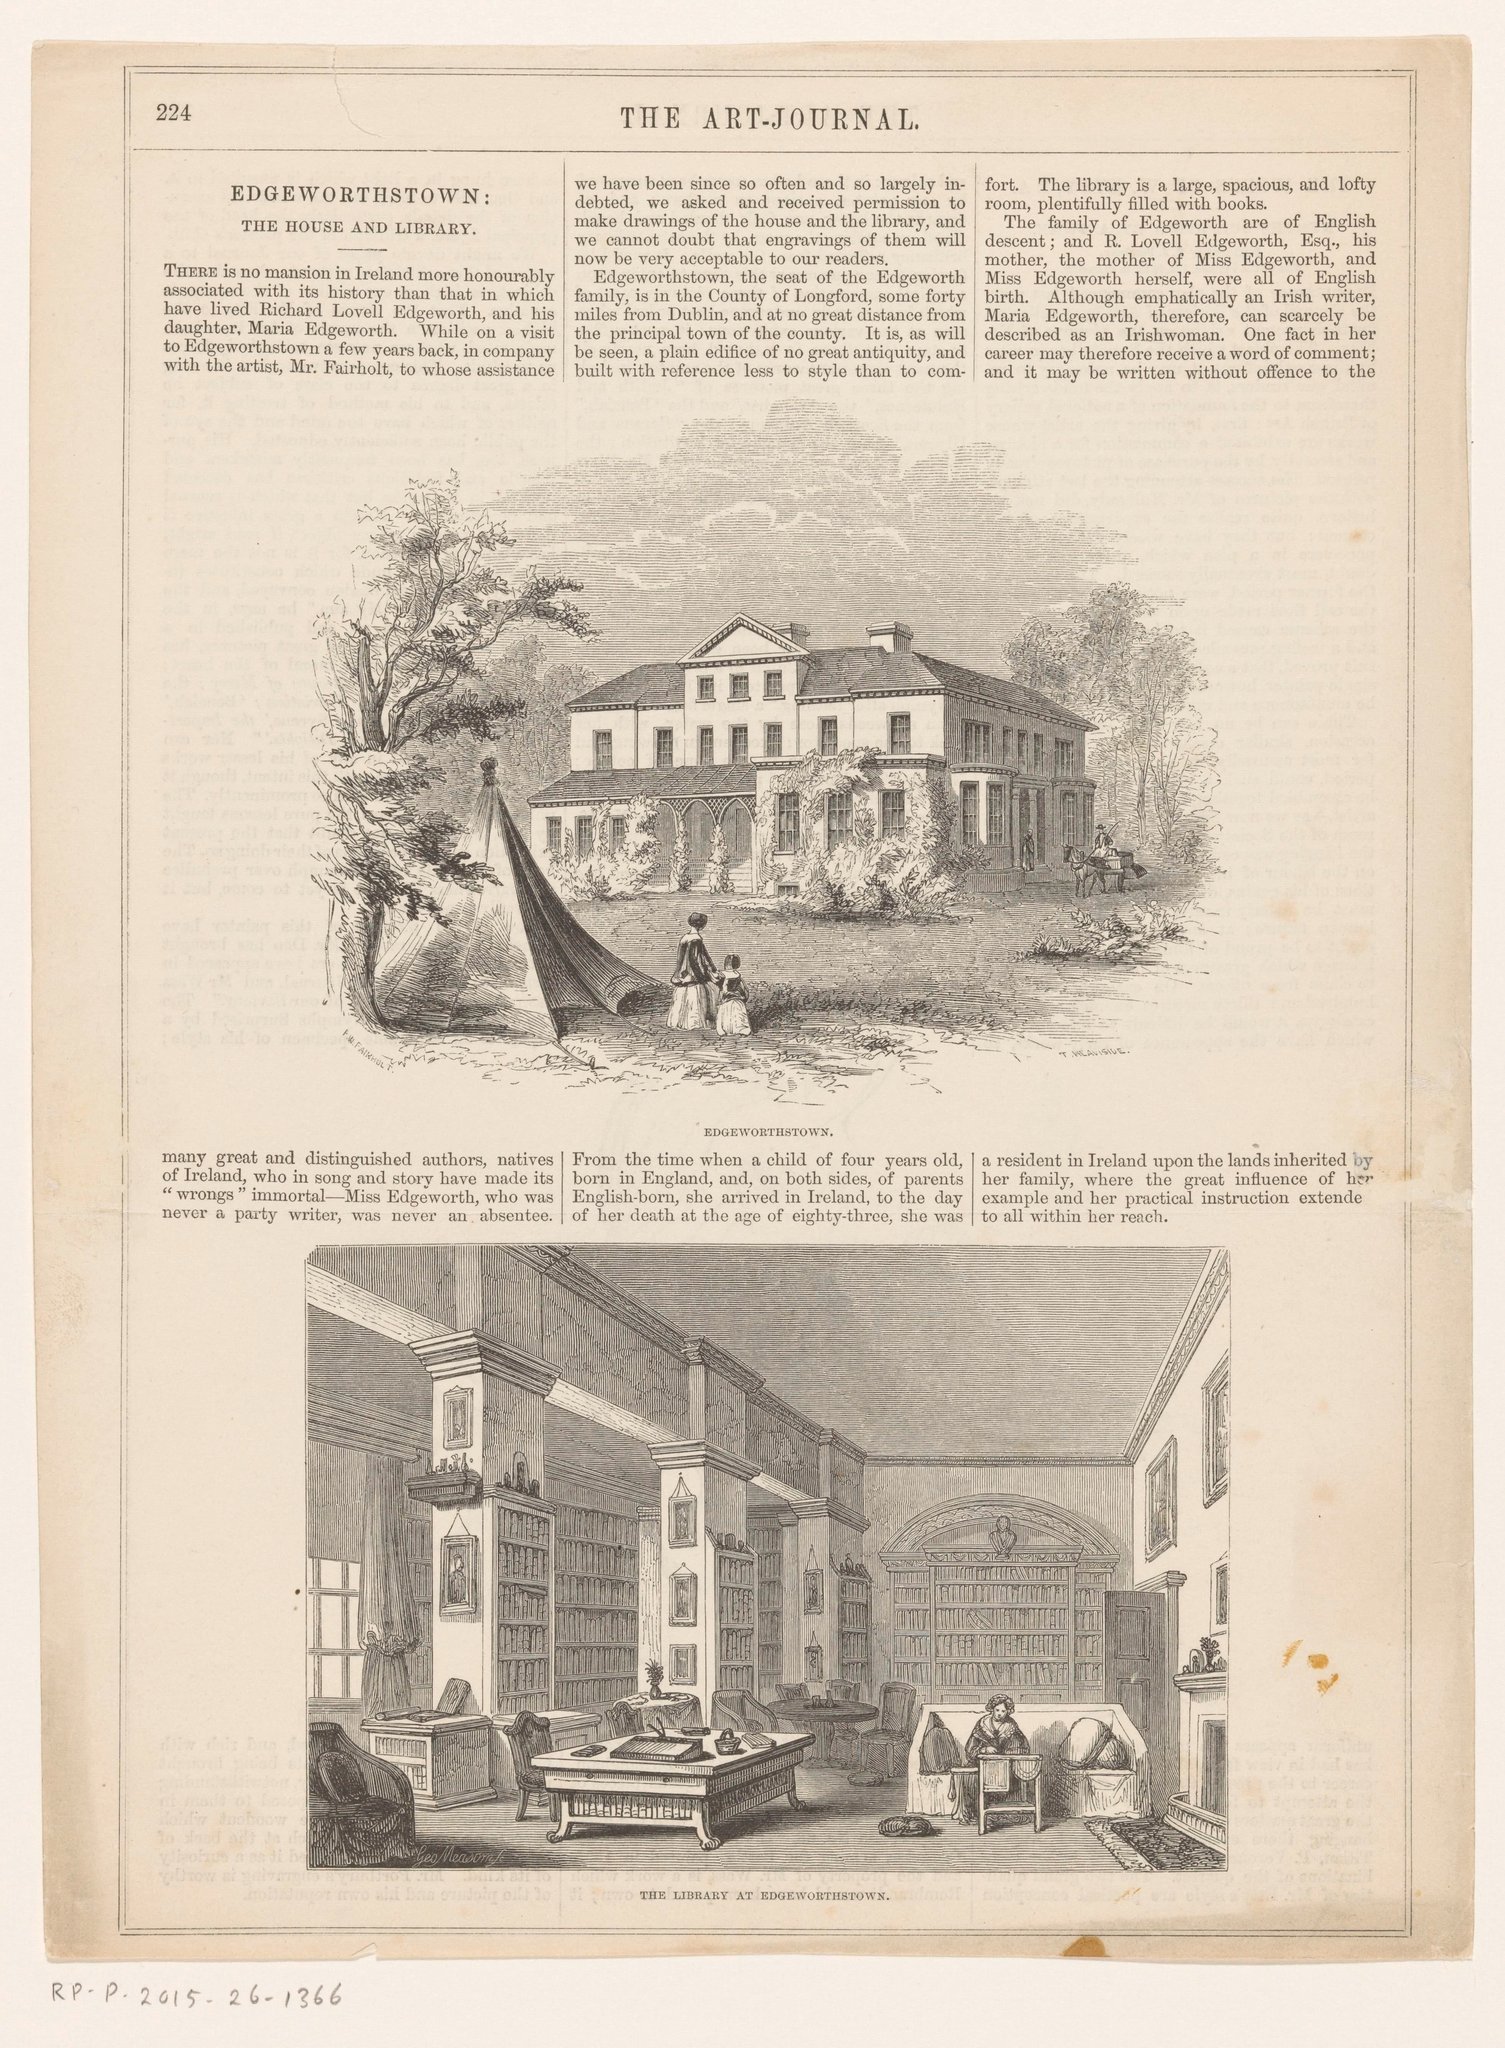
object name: print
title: Gezicht op Edgeworthstown en interieur van de bibliotheek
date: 1849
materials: paper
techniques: engraving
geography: london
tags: rural housing, e.g. country-house, villa, cottage, study; 'studiolo'; library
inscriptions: collector's mark: Lugt 4779, collector's mark: Lugt 2228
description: Twee illustraties op een pagina: boven een gezicht op het huis; onder het interieur van de bibliotheek. Tekst op recto en verso. Linksboven genummerd: 224.